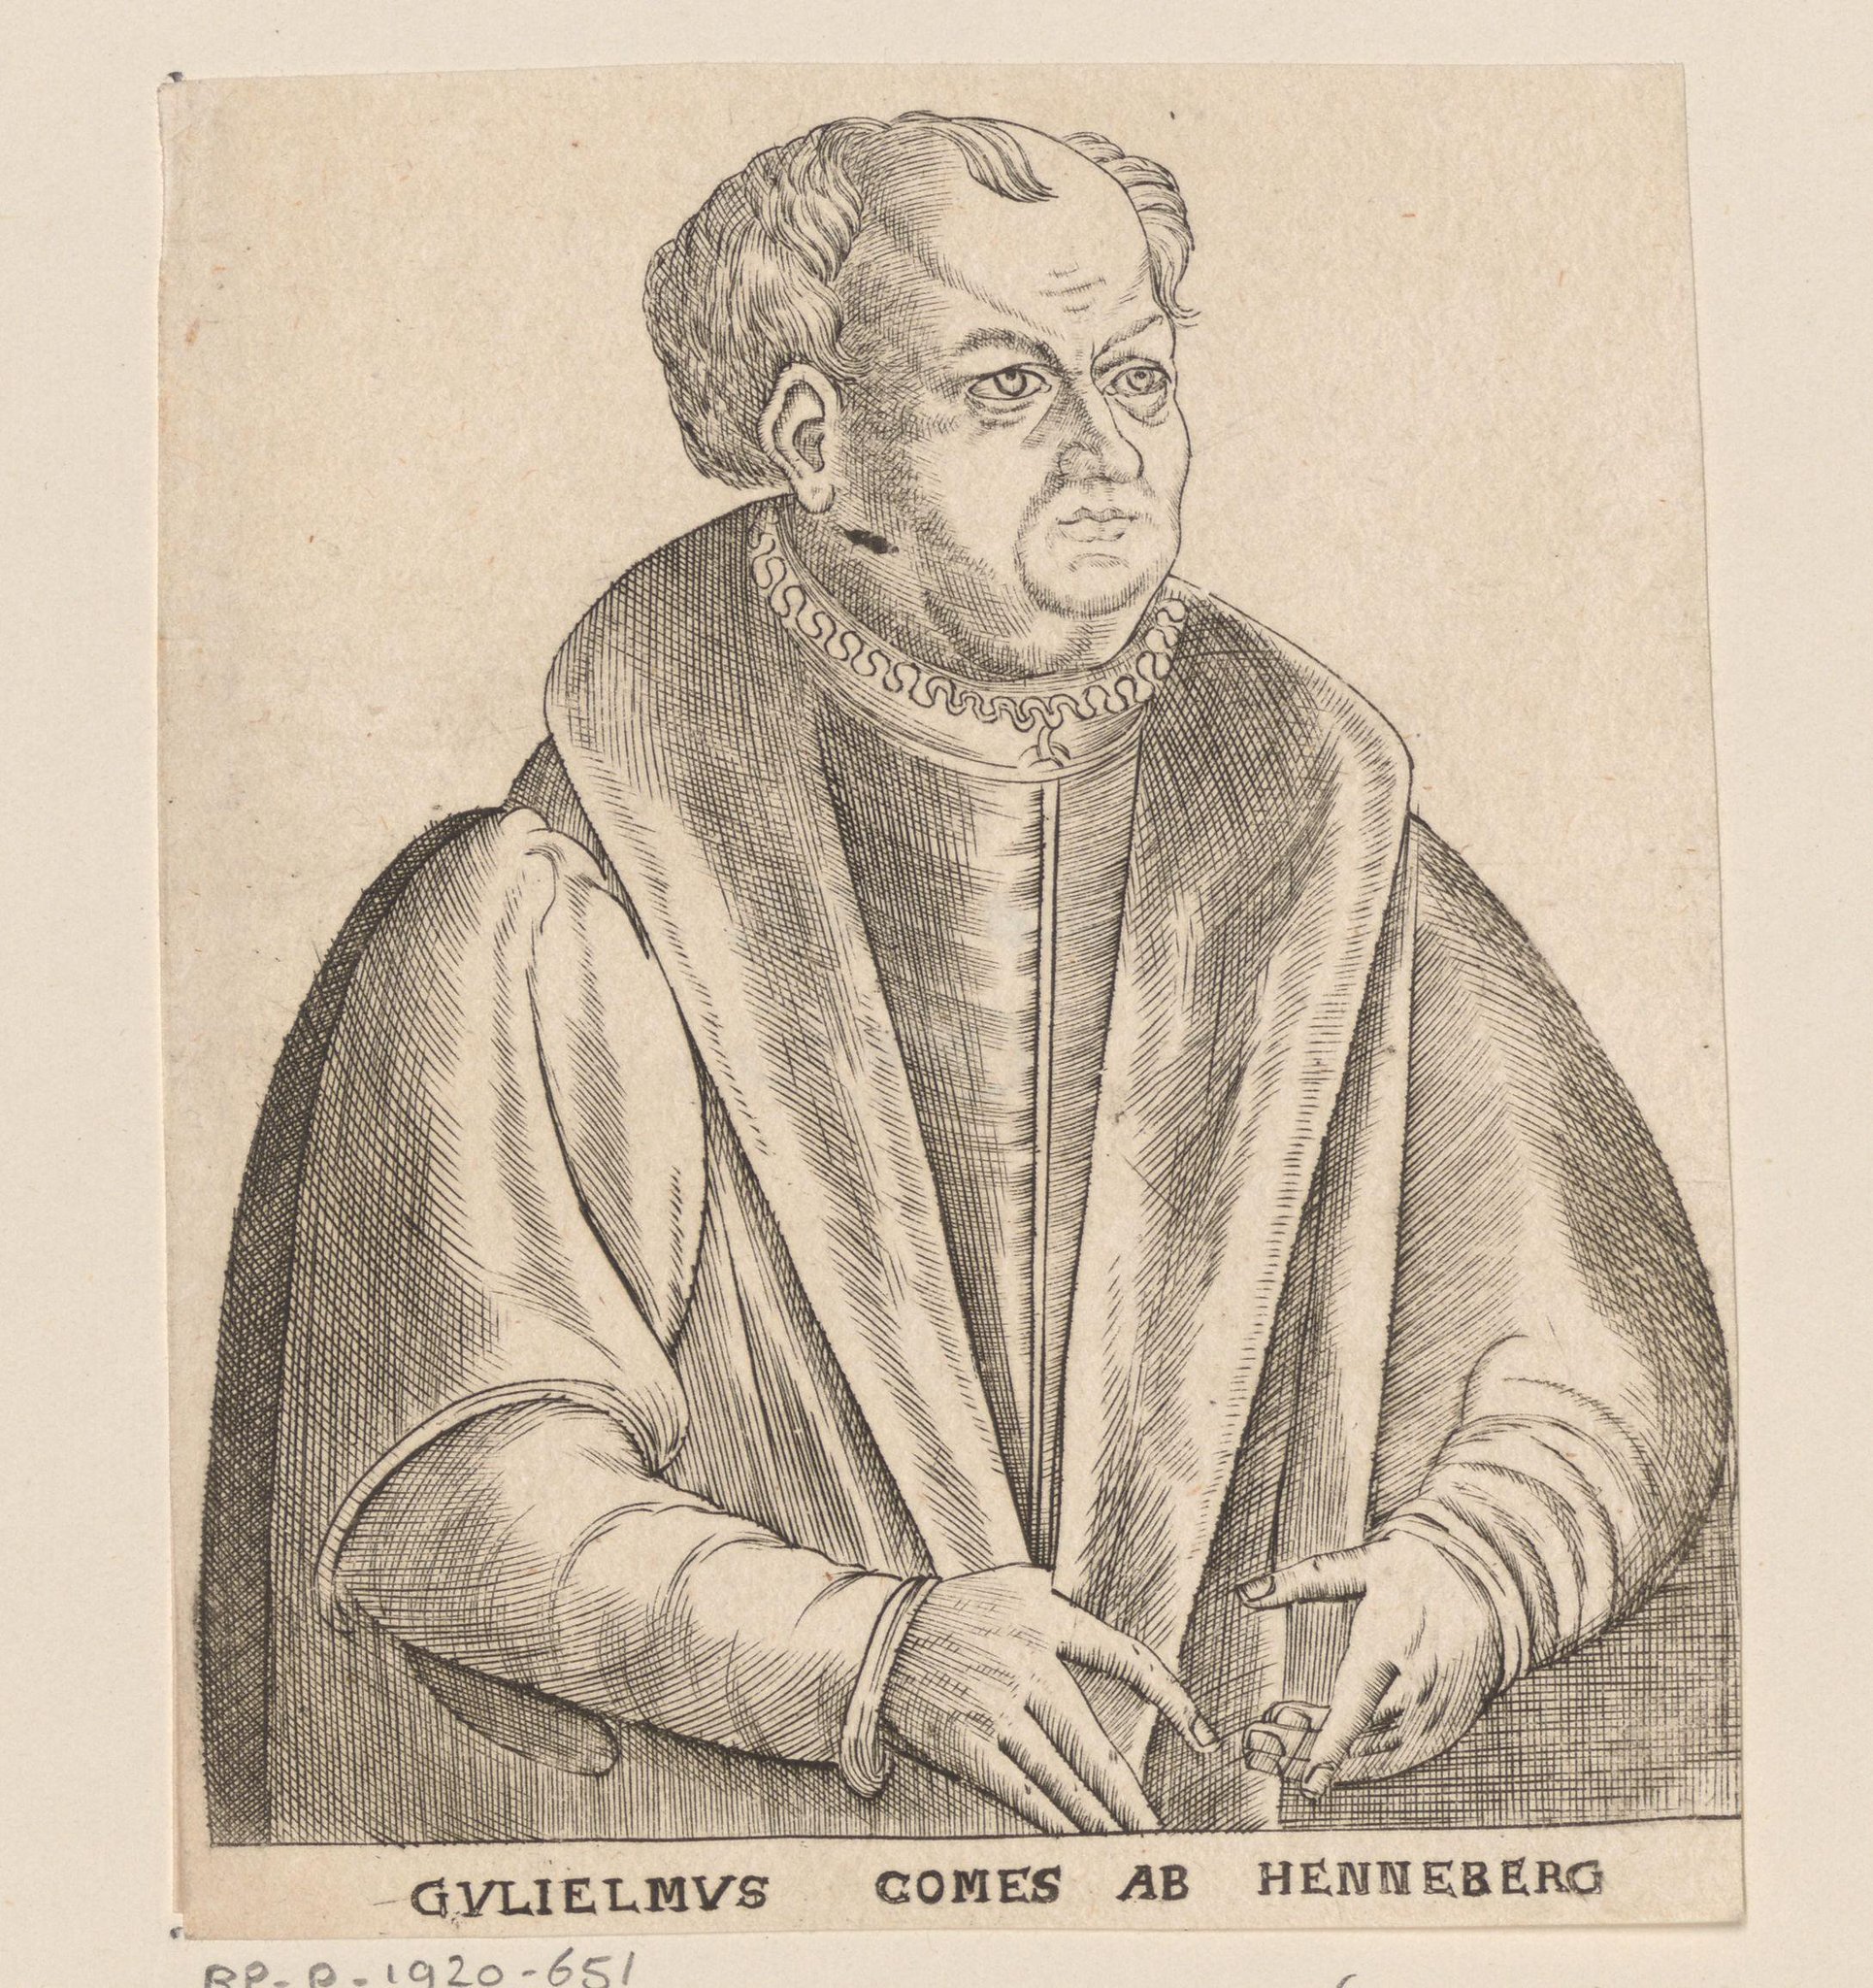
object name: print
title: Portret van Willem, graaf van Henneberg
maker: Anonymous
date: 1650-1749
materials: paper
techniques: engraving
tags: earl, historical persons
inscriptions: collector's mark: Lugt 2228